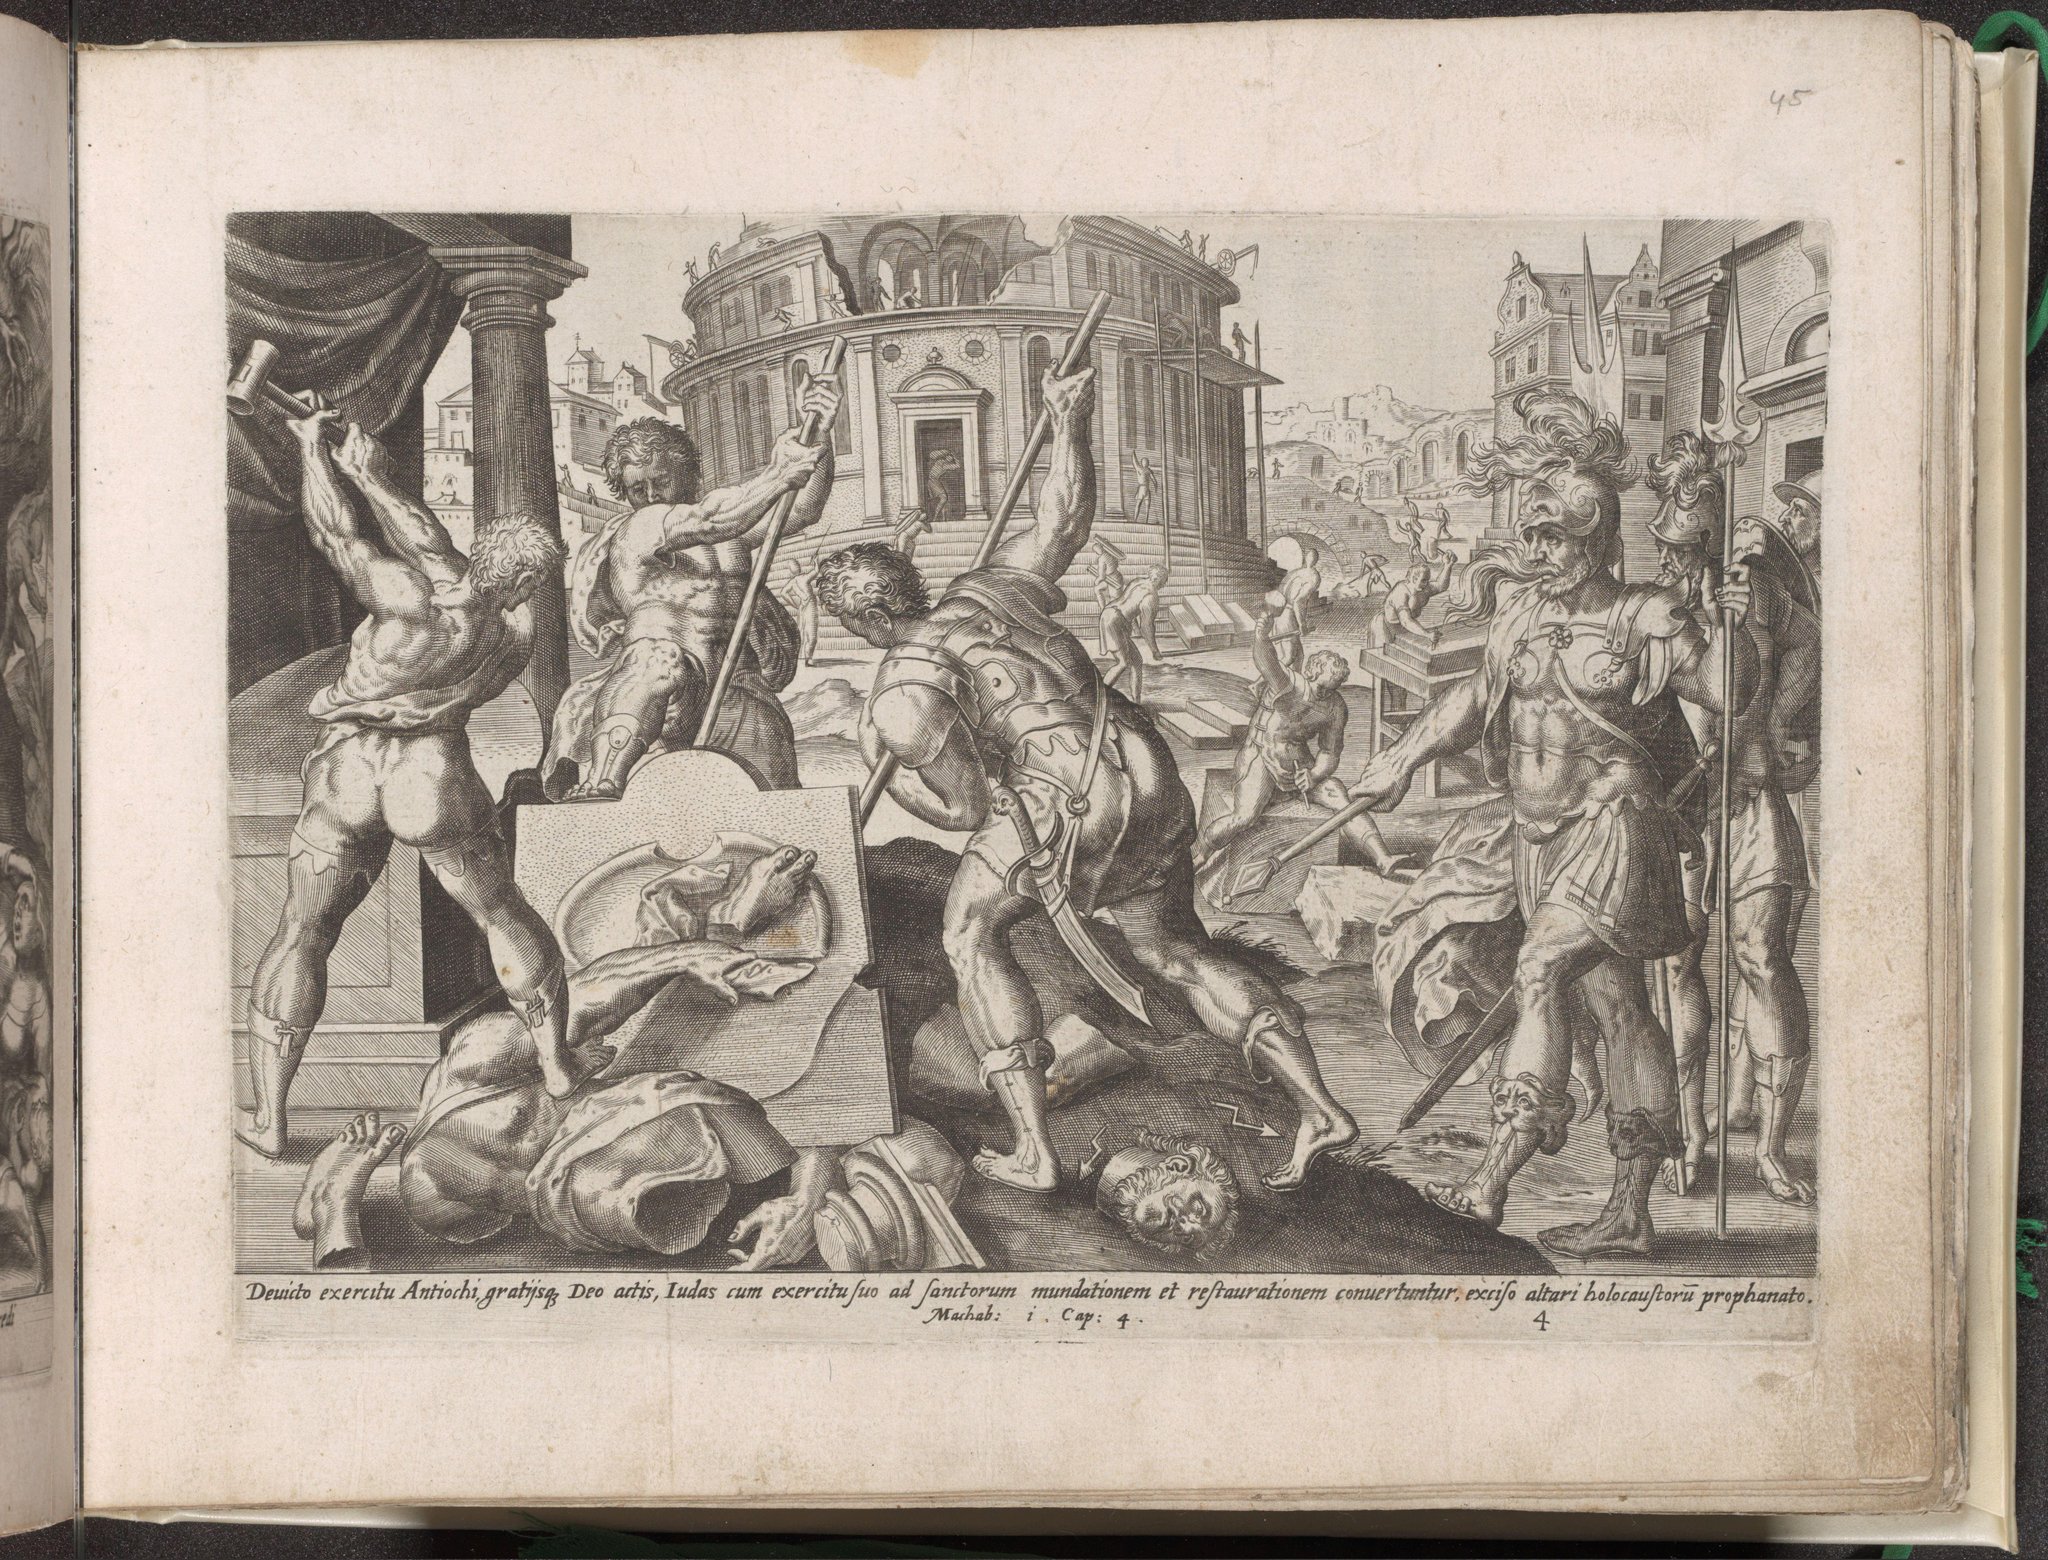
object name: album leaf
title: Geschiedenis van de Makkabeeën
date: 1572-1576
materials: paper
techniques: engraving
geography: antwerp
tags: judas maccabeus has the temple purified and re-dedicated (1 maccabees 4:36-58)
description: Judas Makkabeüs beveelt een aantal wetsgetrouwe priesters het heiligdom te reinigen en de stenen die het altaar ontwijd hebben af te voeren naar een onreine plaats. Het ontwijde brandofferaltaar wordt afgebroken. Onder de voorstelling een verwijzing in het Latijn naar de Bijbeltekst in 1 Makk. 4. Deze prent maakt deel uit van een album.